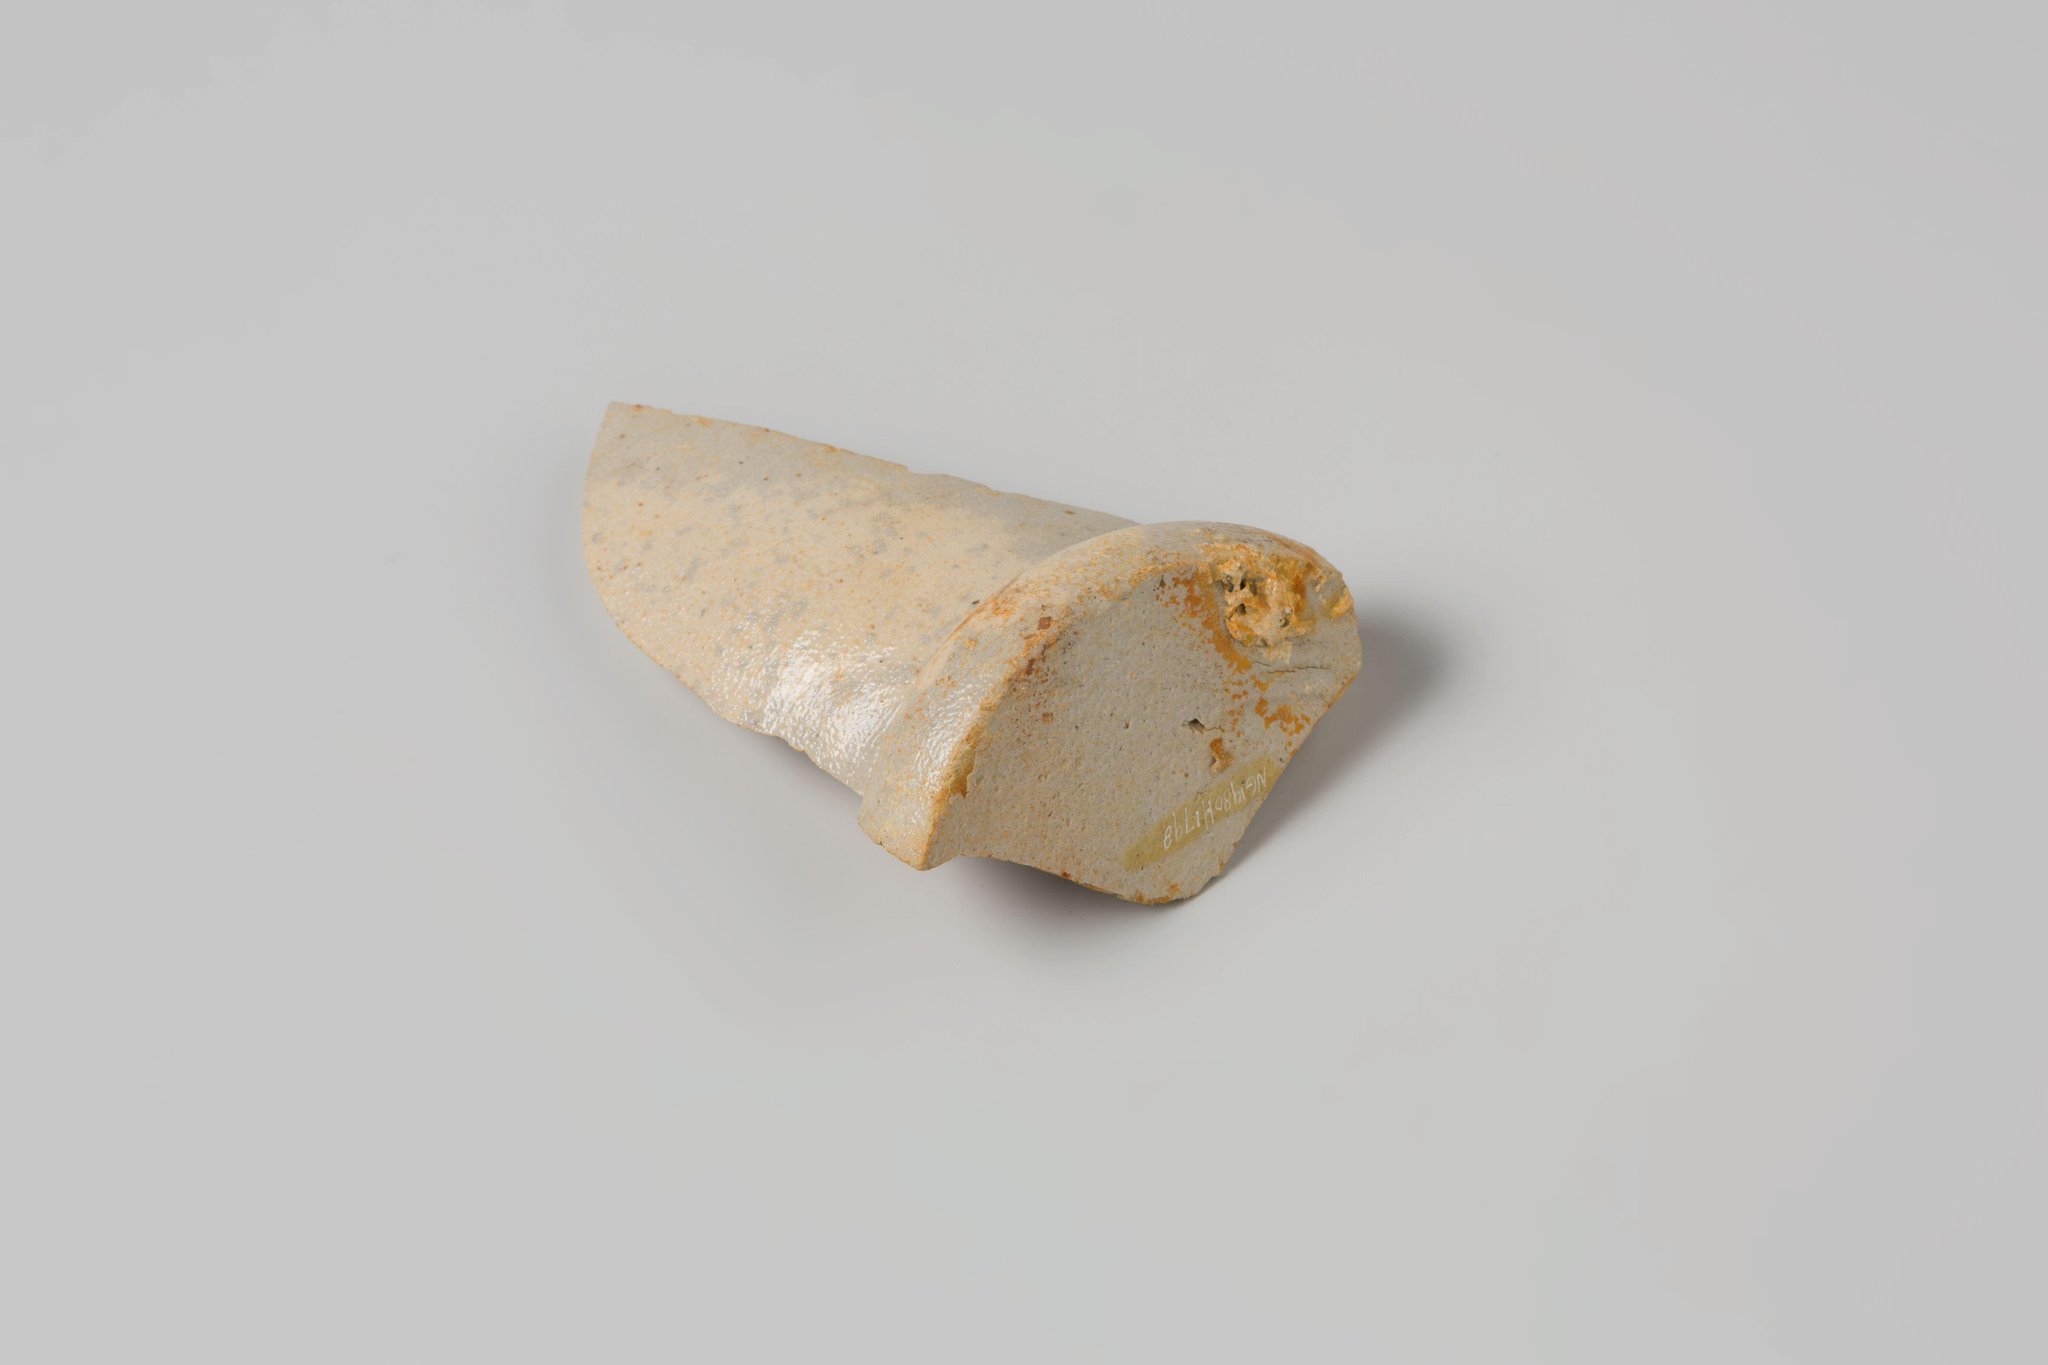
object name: ewer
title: Scherf van een kan uit het wrak van de Oost-Indiëvaarder Hollandia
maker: Anonymous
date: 1700-1743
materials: stoneware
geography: westerwald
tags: verenigde oostindische compagnie, hollandia (schip), annet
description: Stoneware, Rhenish, Westerwald, jug; (1)fragm of base, sim. NG 1980-27H2615.